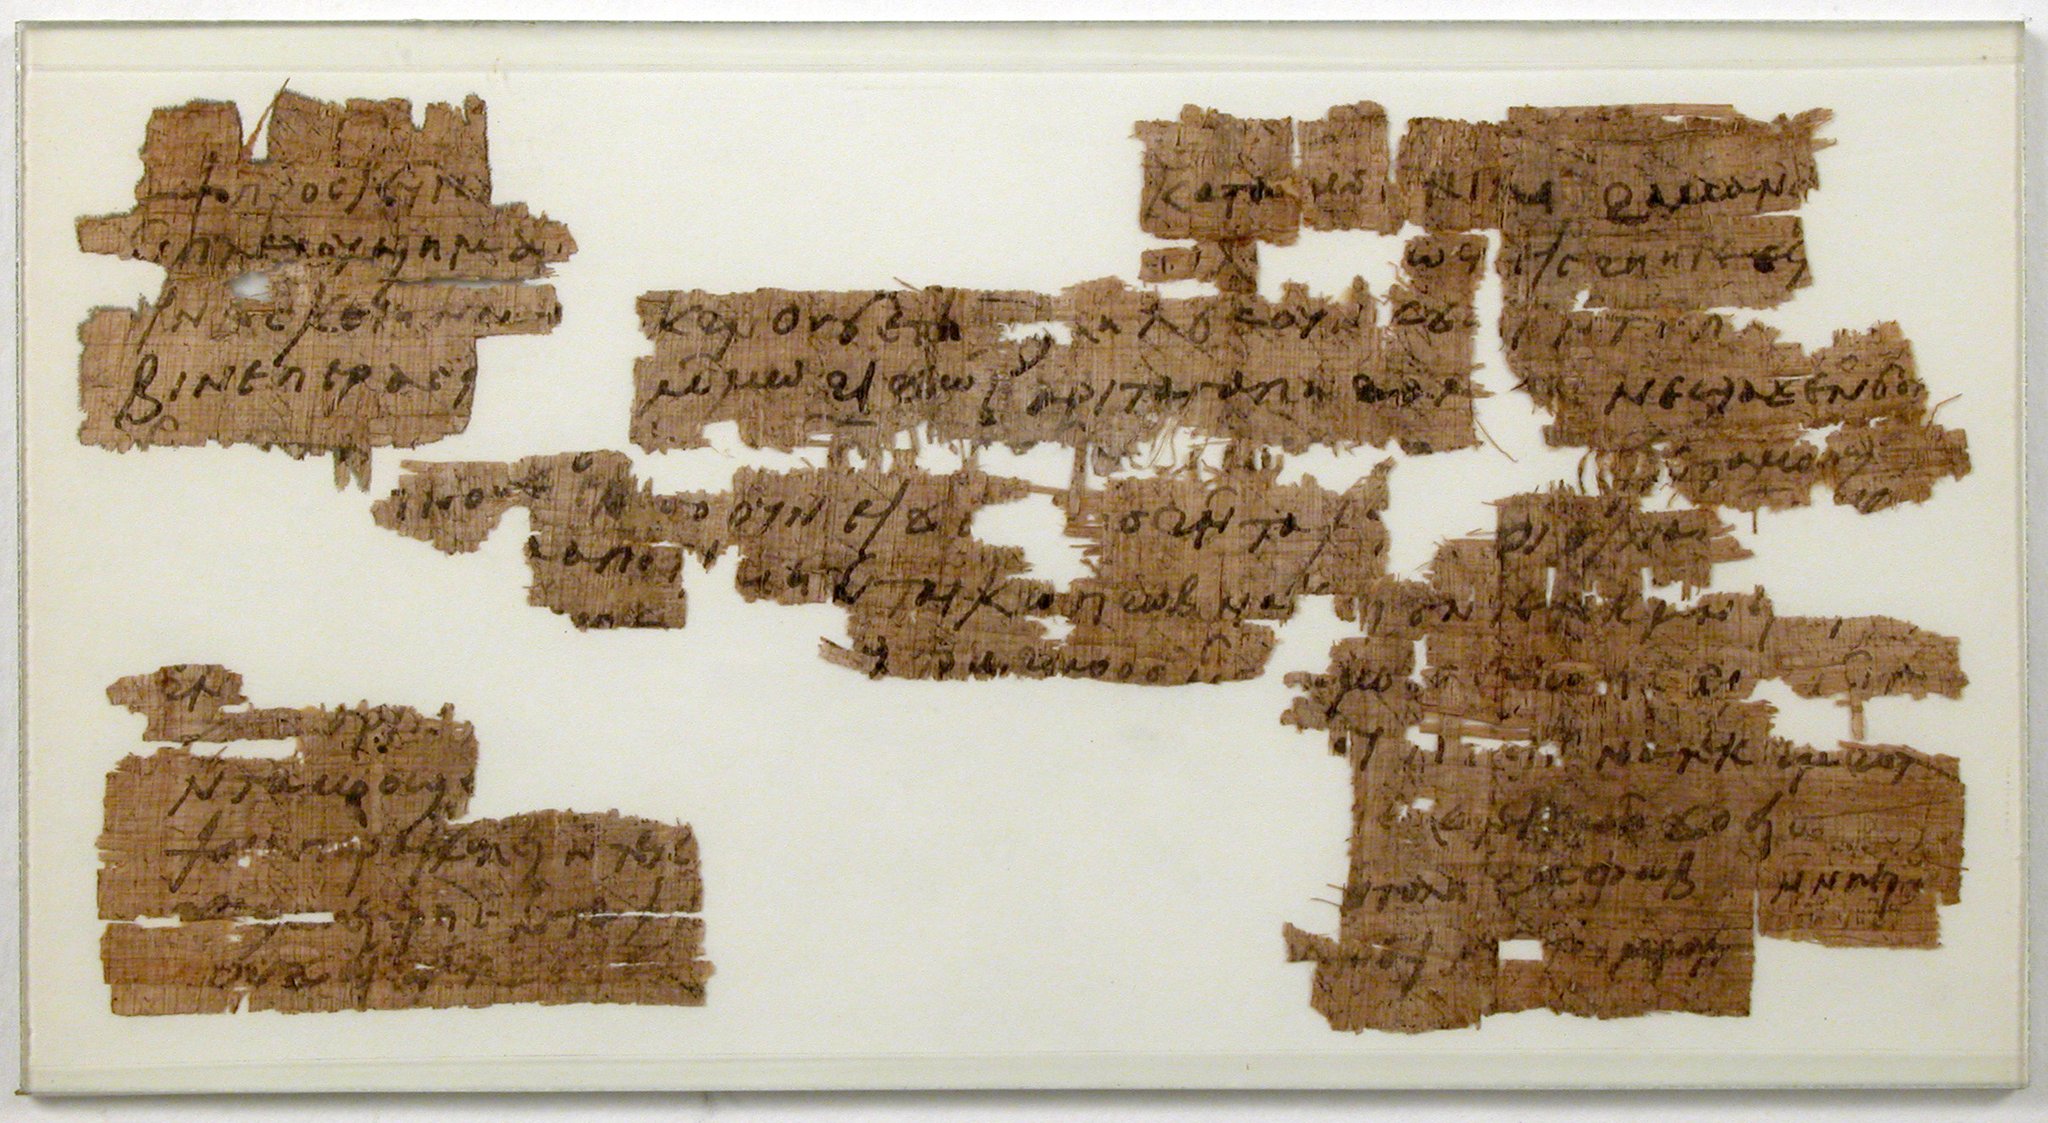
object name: fragment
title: Papyri Fragments of a Letter from Tagape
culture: coptic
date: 601-700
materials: ink, papyrus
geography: egypt